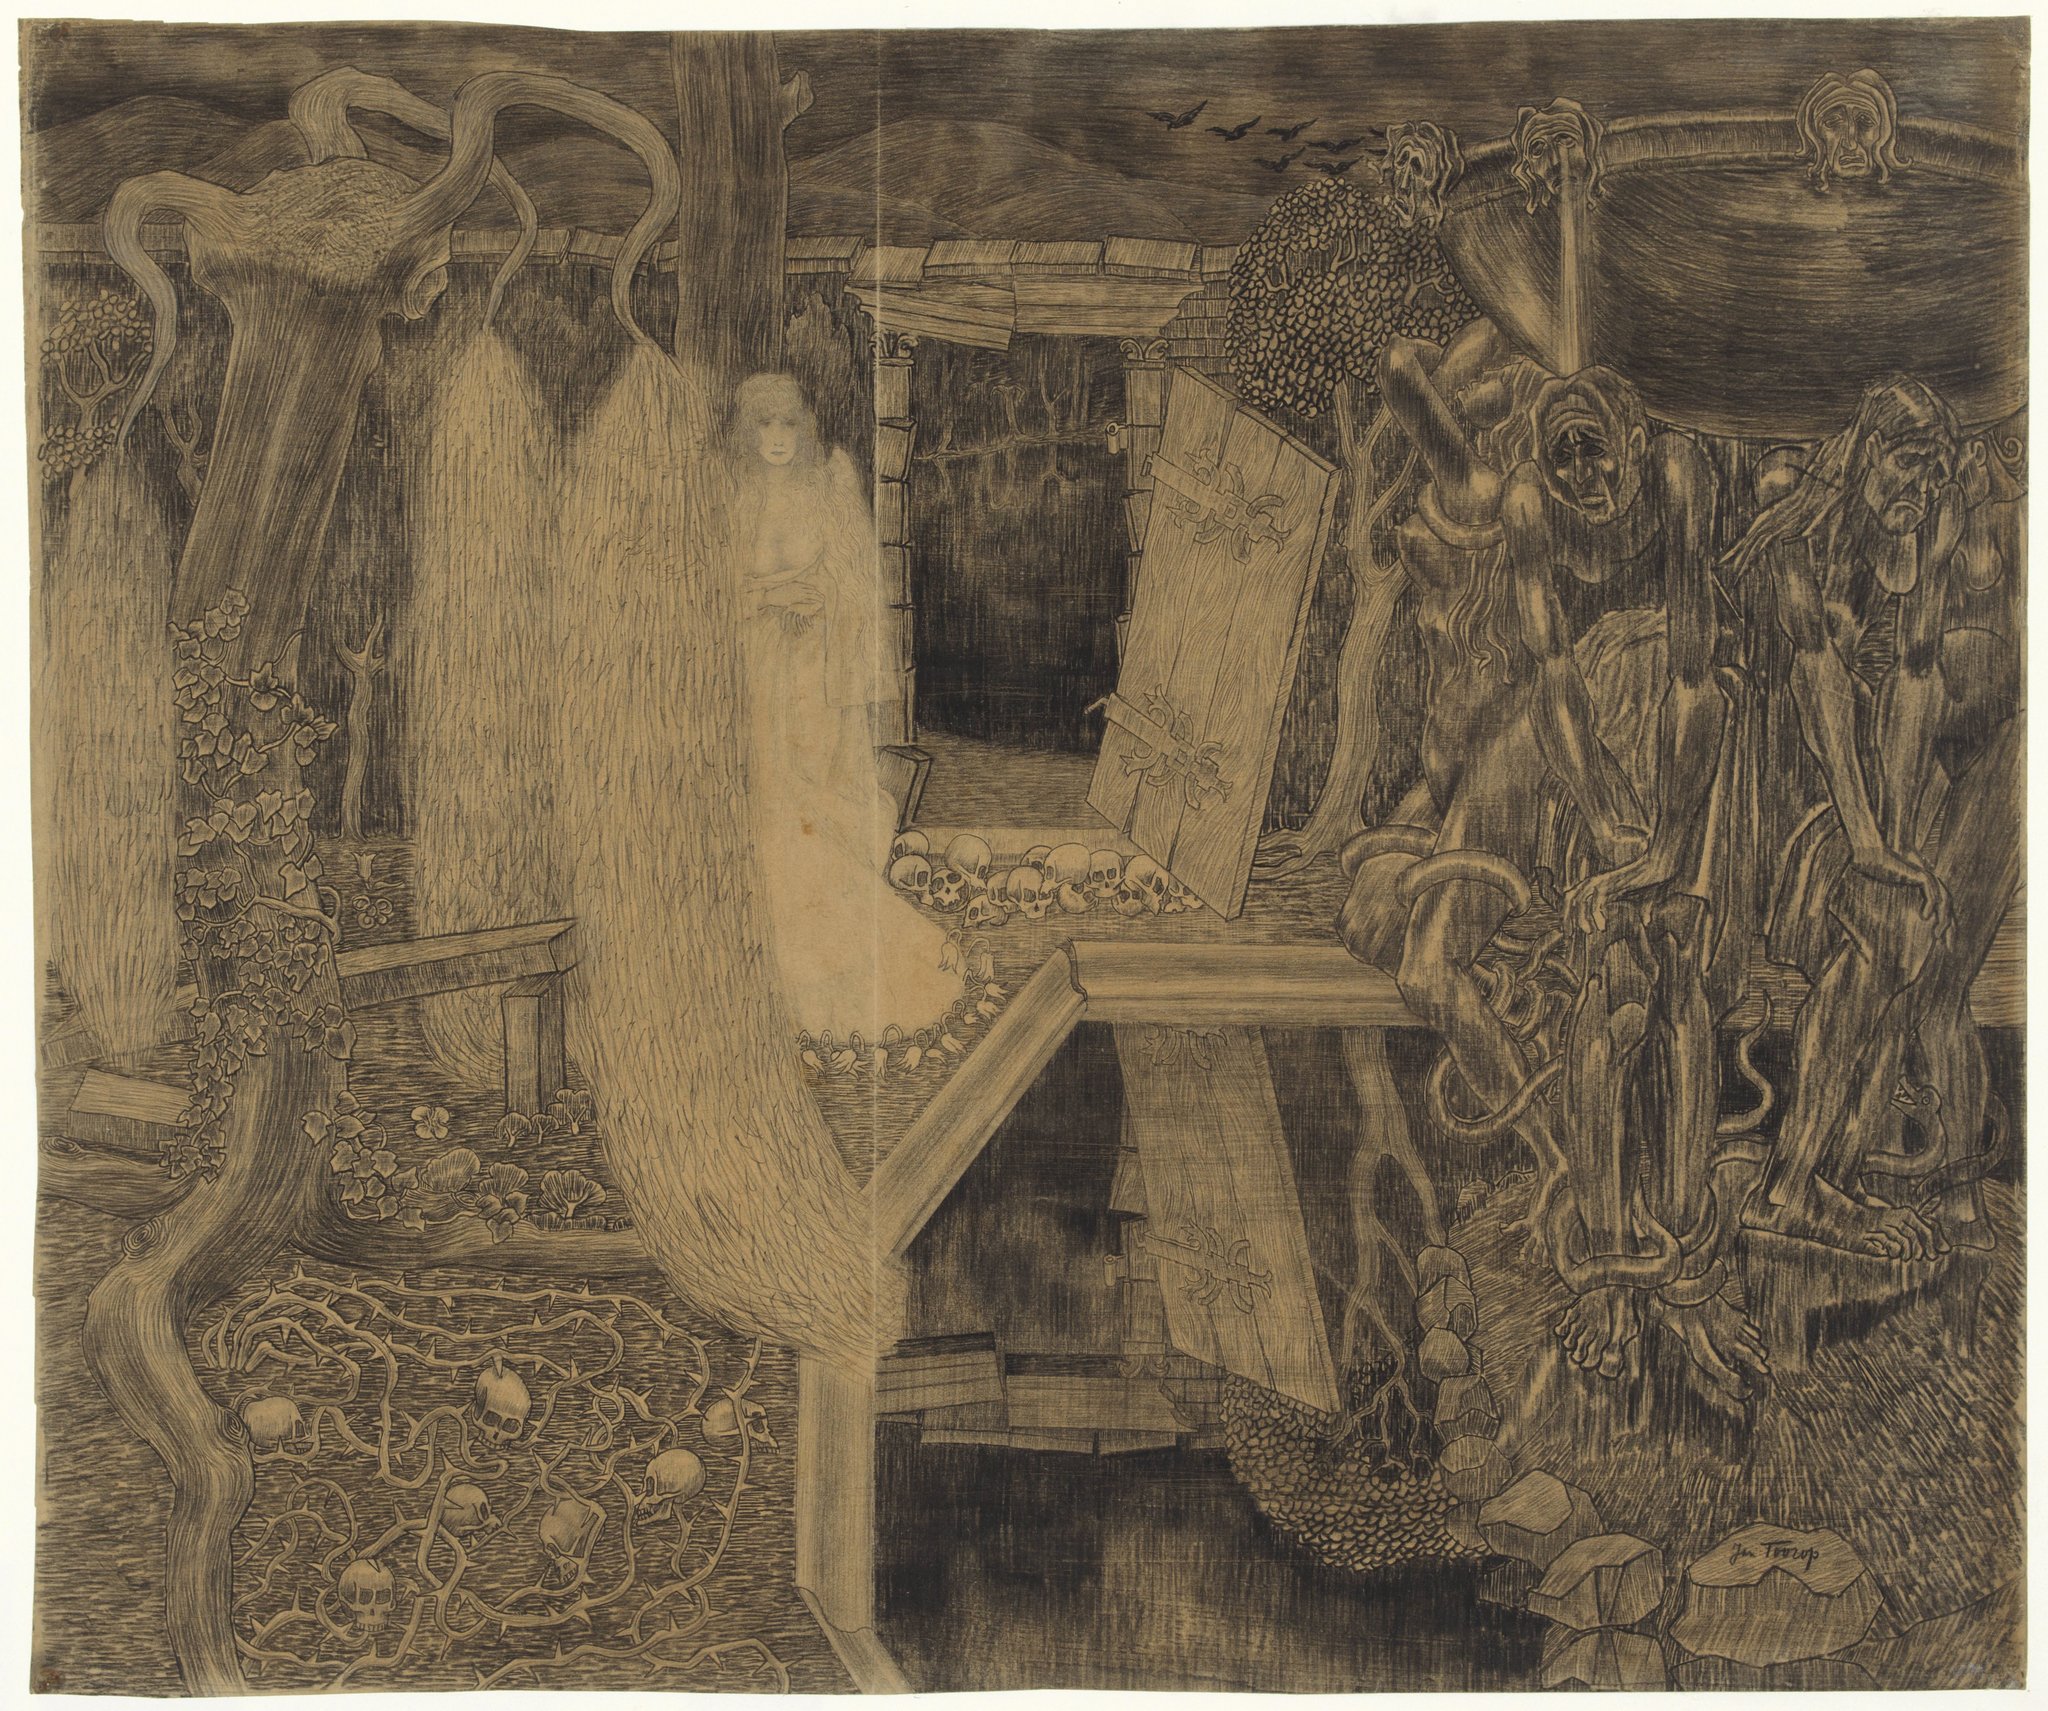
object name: drawing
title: The Old Garden of Sorrows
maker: jan toorop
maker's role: draughtsman, painter, print maker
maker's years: 1858-1928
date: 1889-1890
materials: chalk, paper, pencil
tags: adult woman, garden, trees: willow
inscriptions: signature: ‘Jan Toorop’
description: According to Toorop, the ‘Old Garden of Sorrows’ is the place where the Soul, here personified as a woman, resides temporarily prior to death. She walks through the walled garden, terrified. Death is symbolized by the skulls strewn on the ground around her and near the dilapidated garden gate. At the right, mourning phantom-like figures support the fountain of tears.